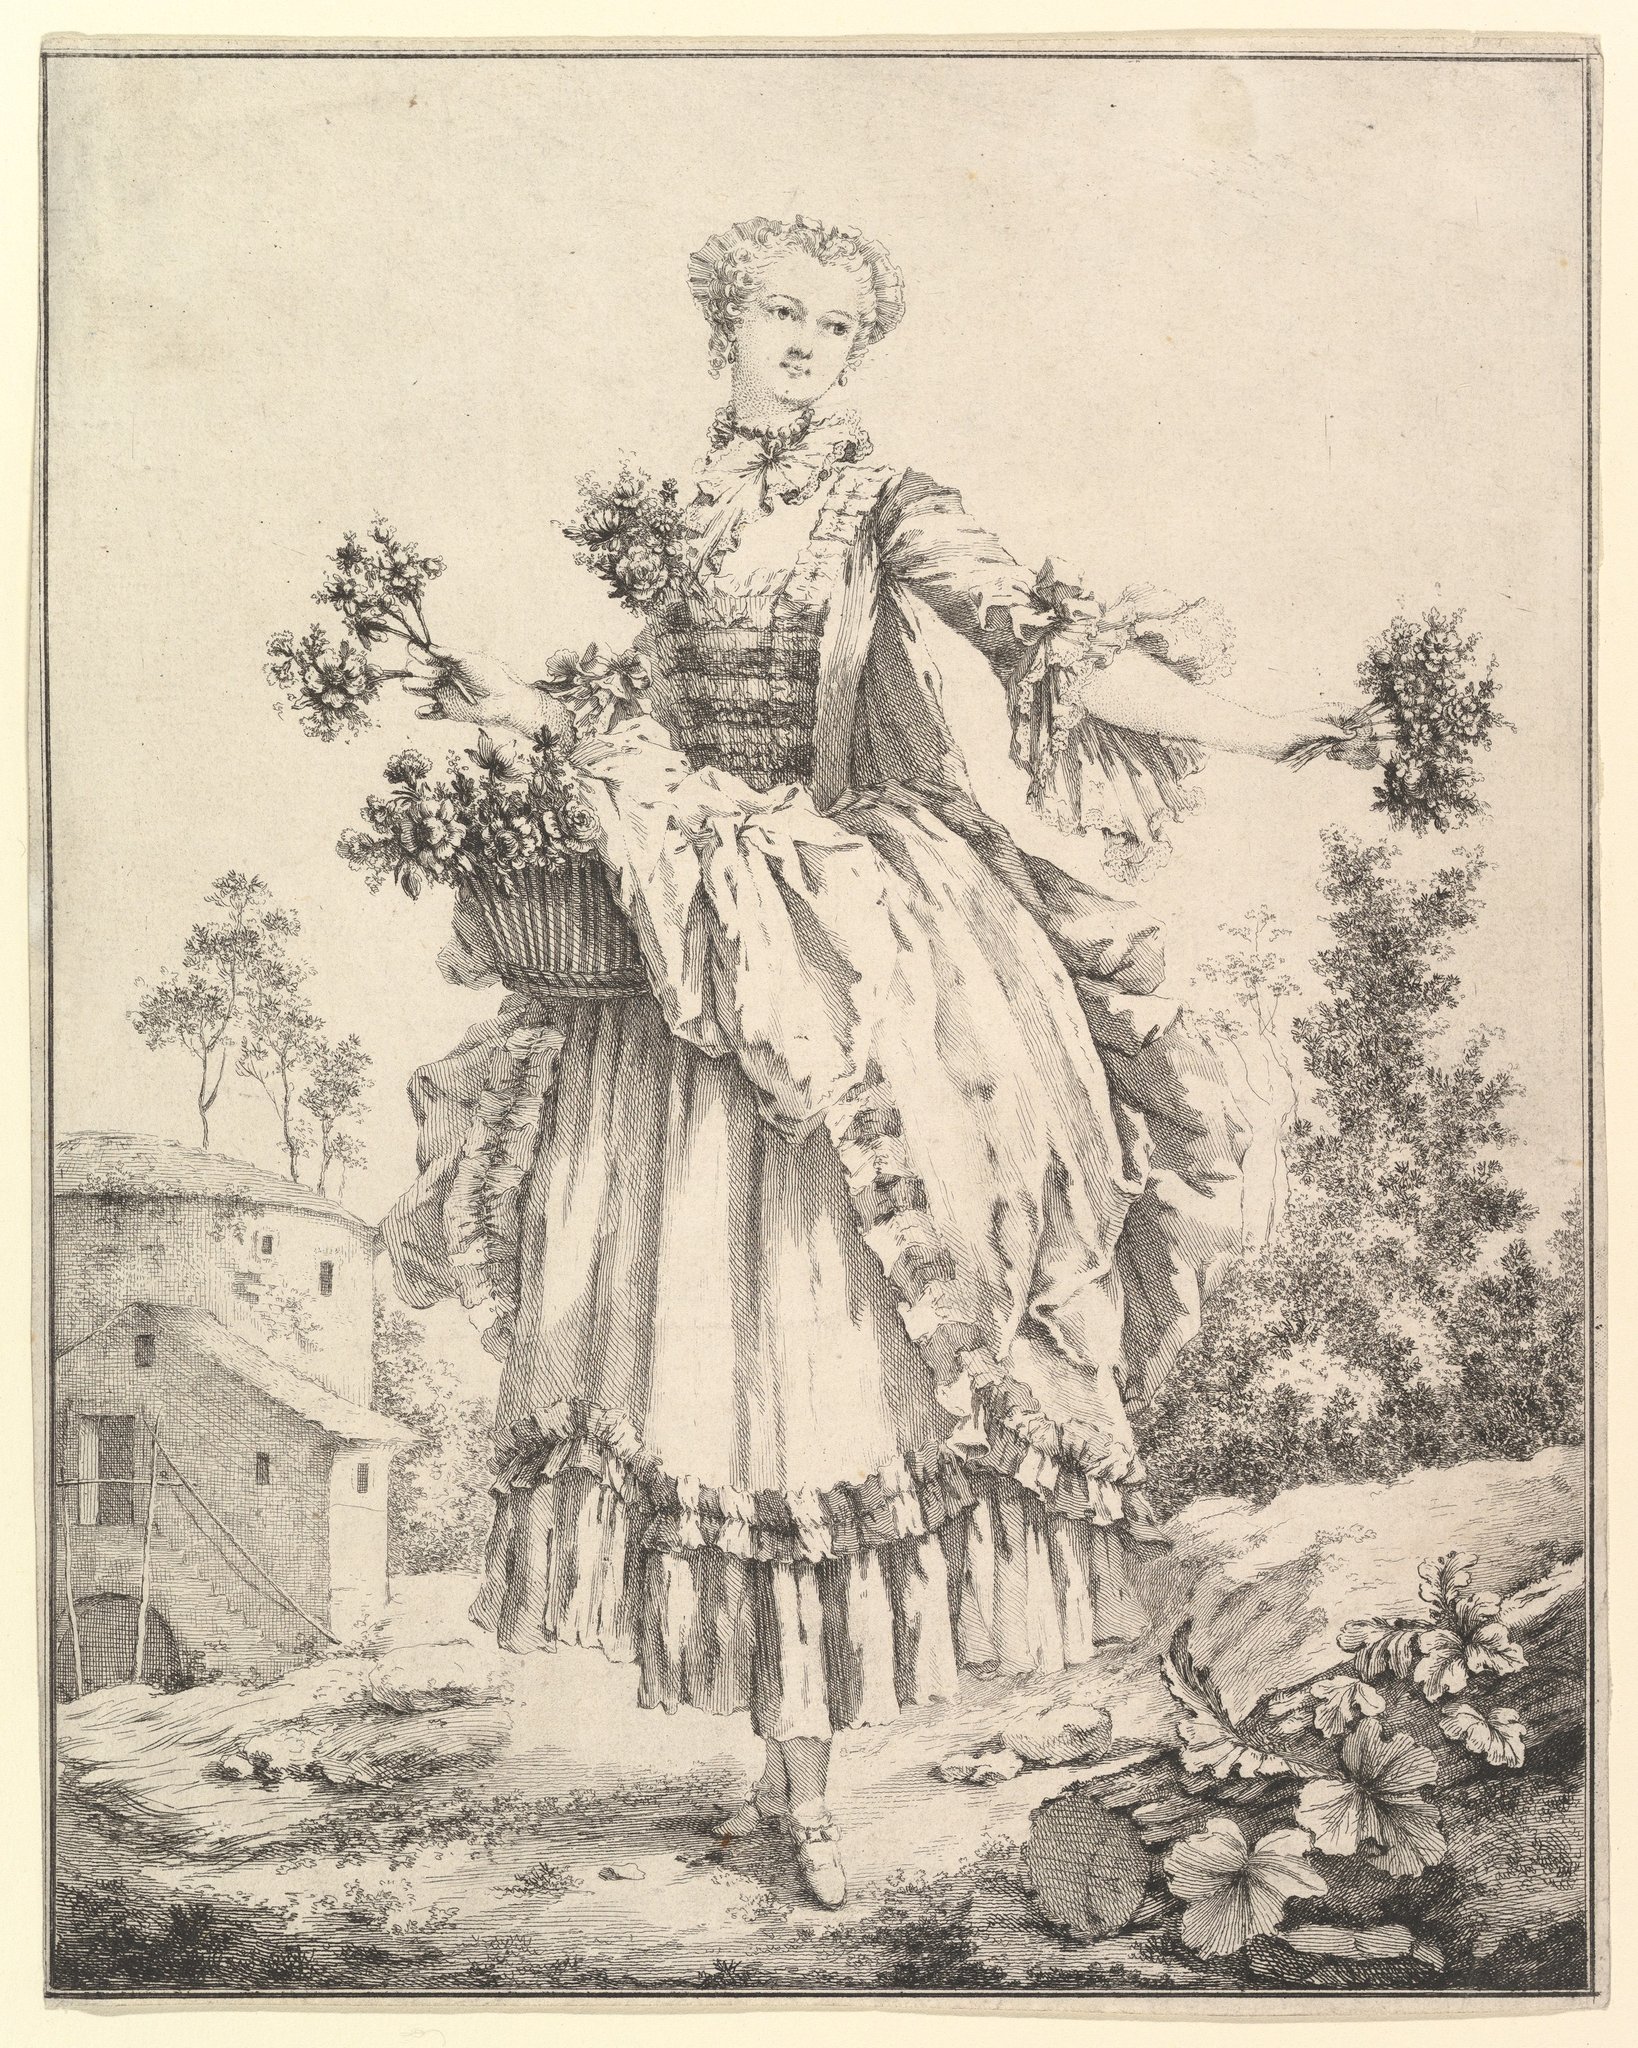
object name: print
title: Flower Girl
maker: françois boucher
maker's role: artist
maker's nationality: french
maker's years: 1703-1770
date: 1701-1800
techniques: etching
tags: women,flowers